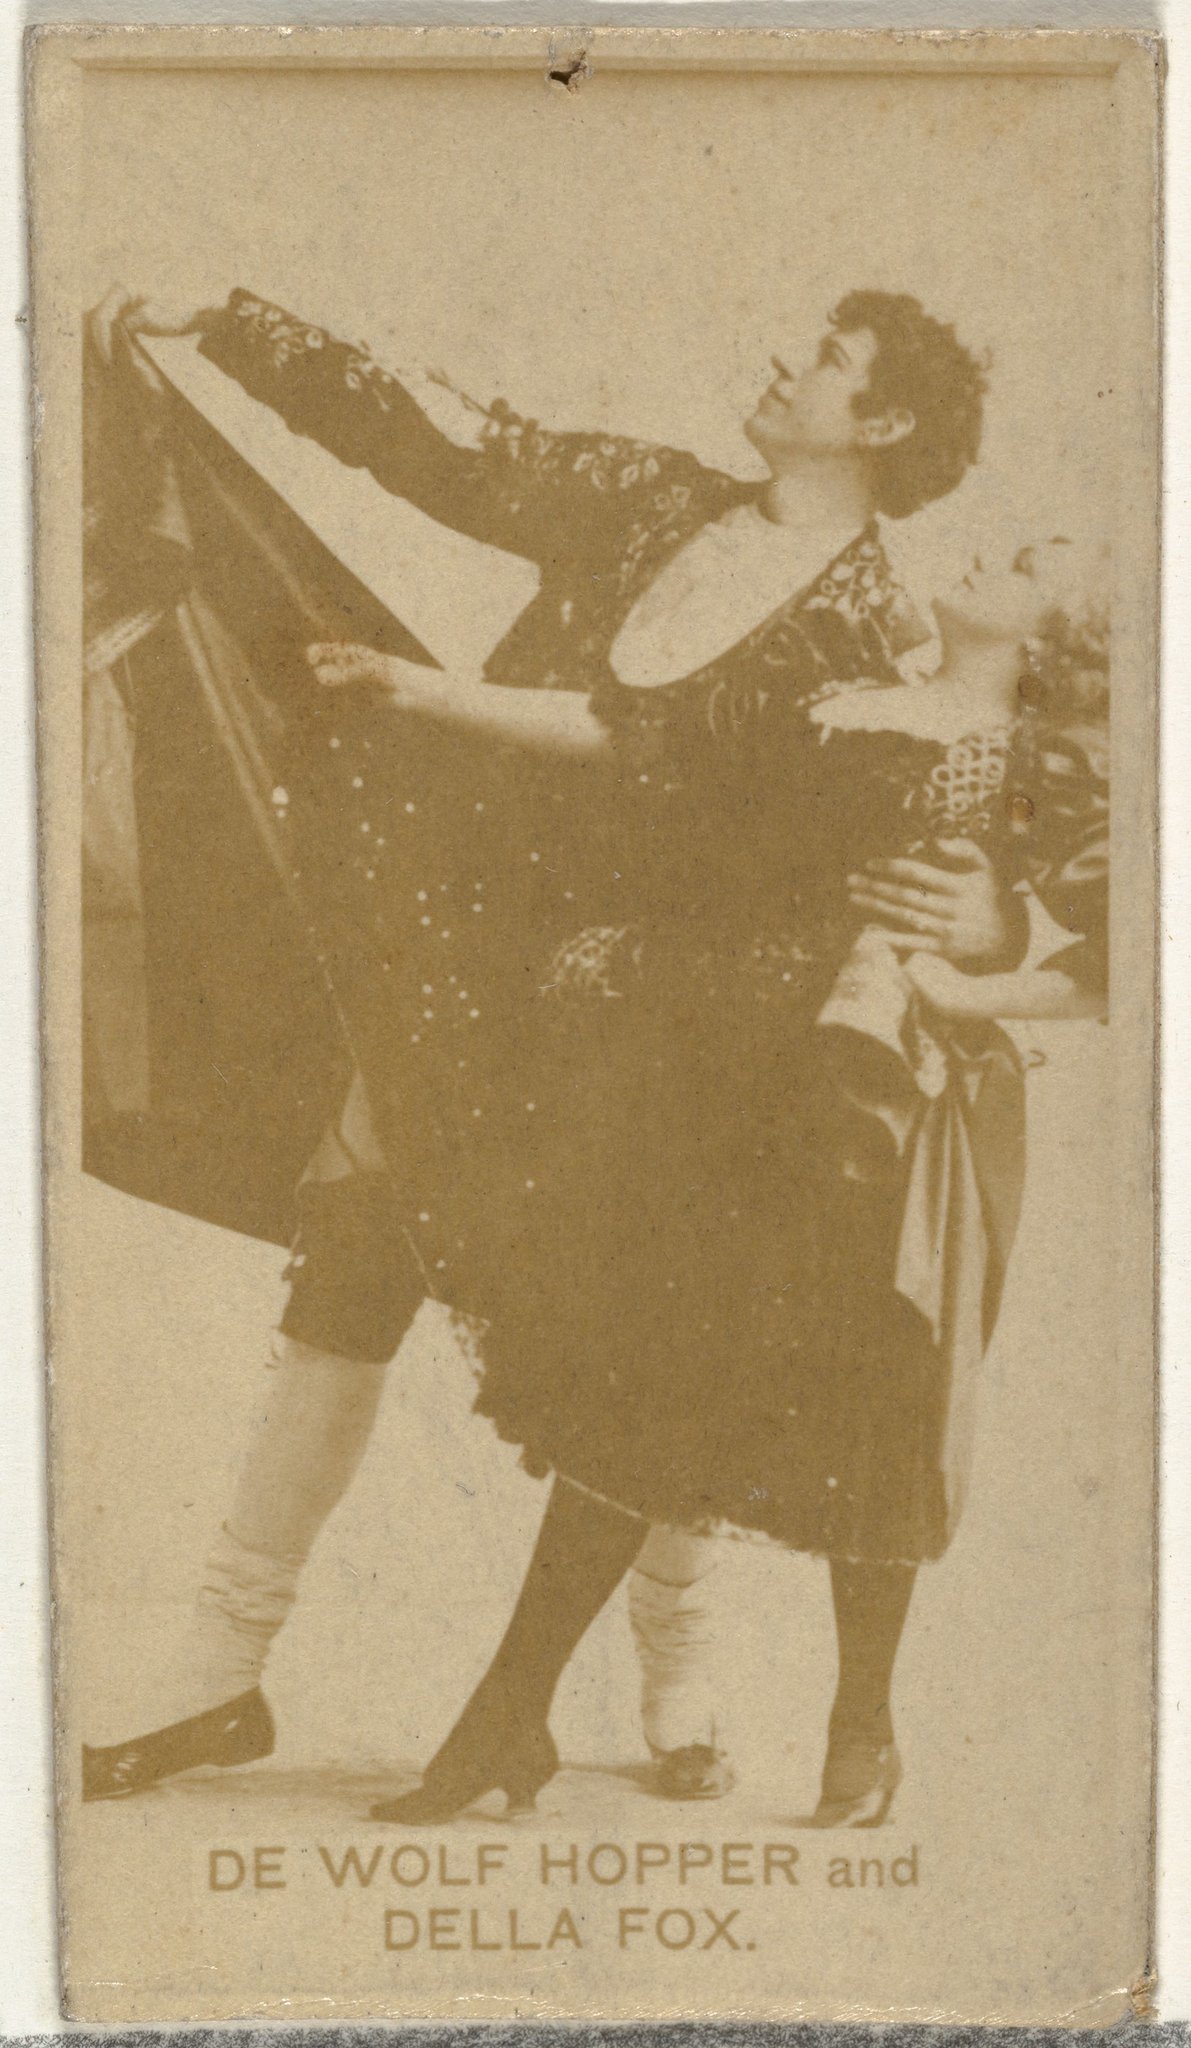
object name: photograph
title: De Wolf Hopper and Della Fox, from the Actors and Actresses series (N145-8) issued by Duke Sons & Co. to promote Duke Cigarettes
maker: w. duke, sons & co.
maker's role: publisher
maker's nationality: american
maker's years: 1870-1920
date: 1891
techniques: albumen silver print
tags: men,portraits,women,actors